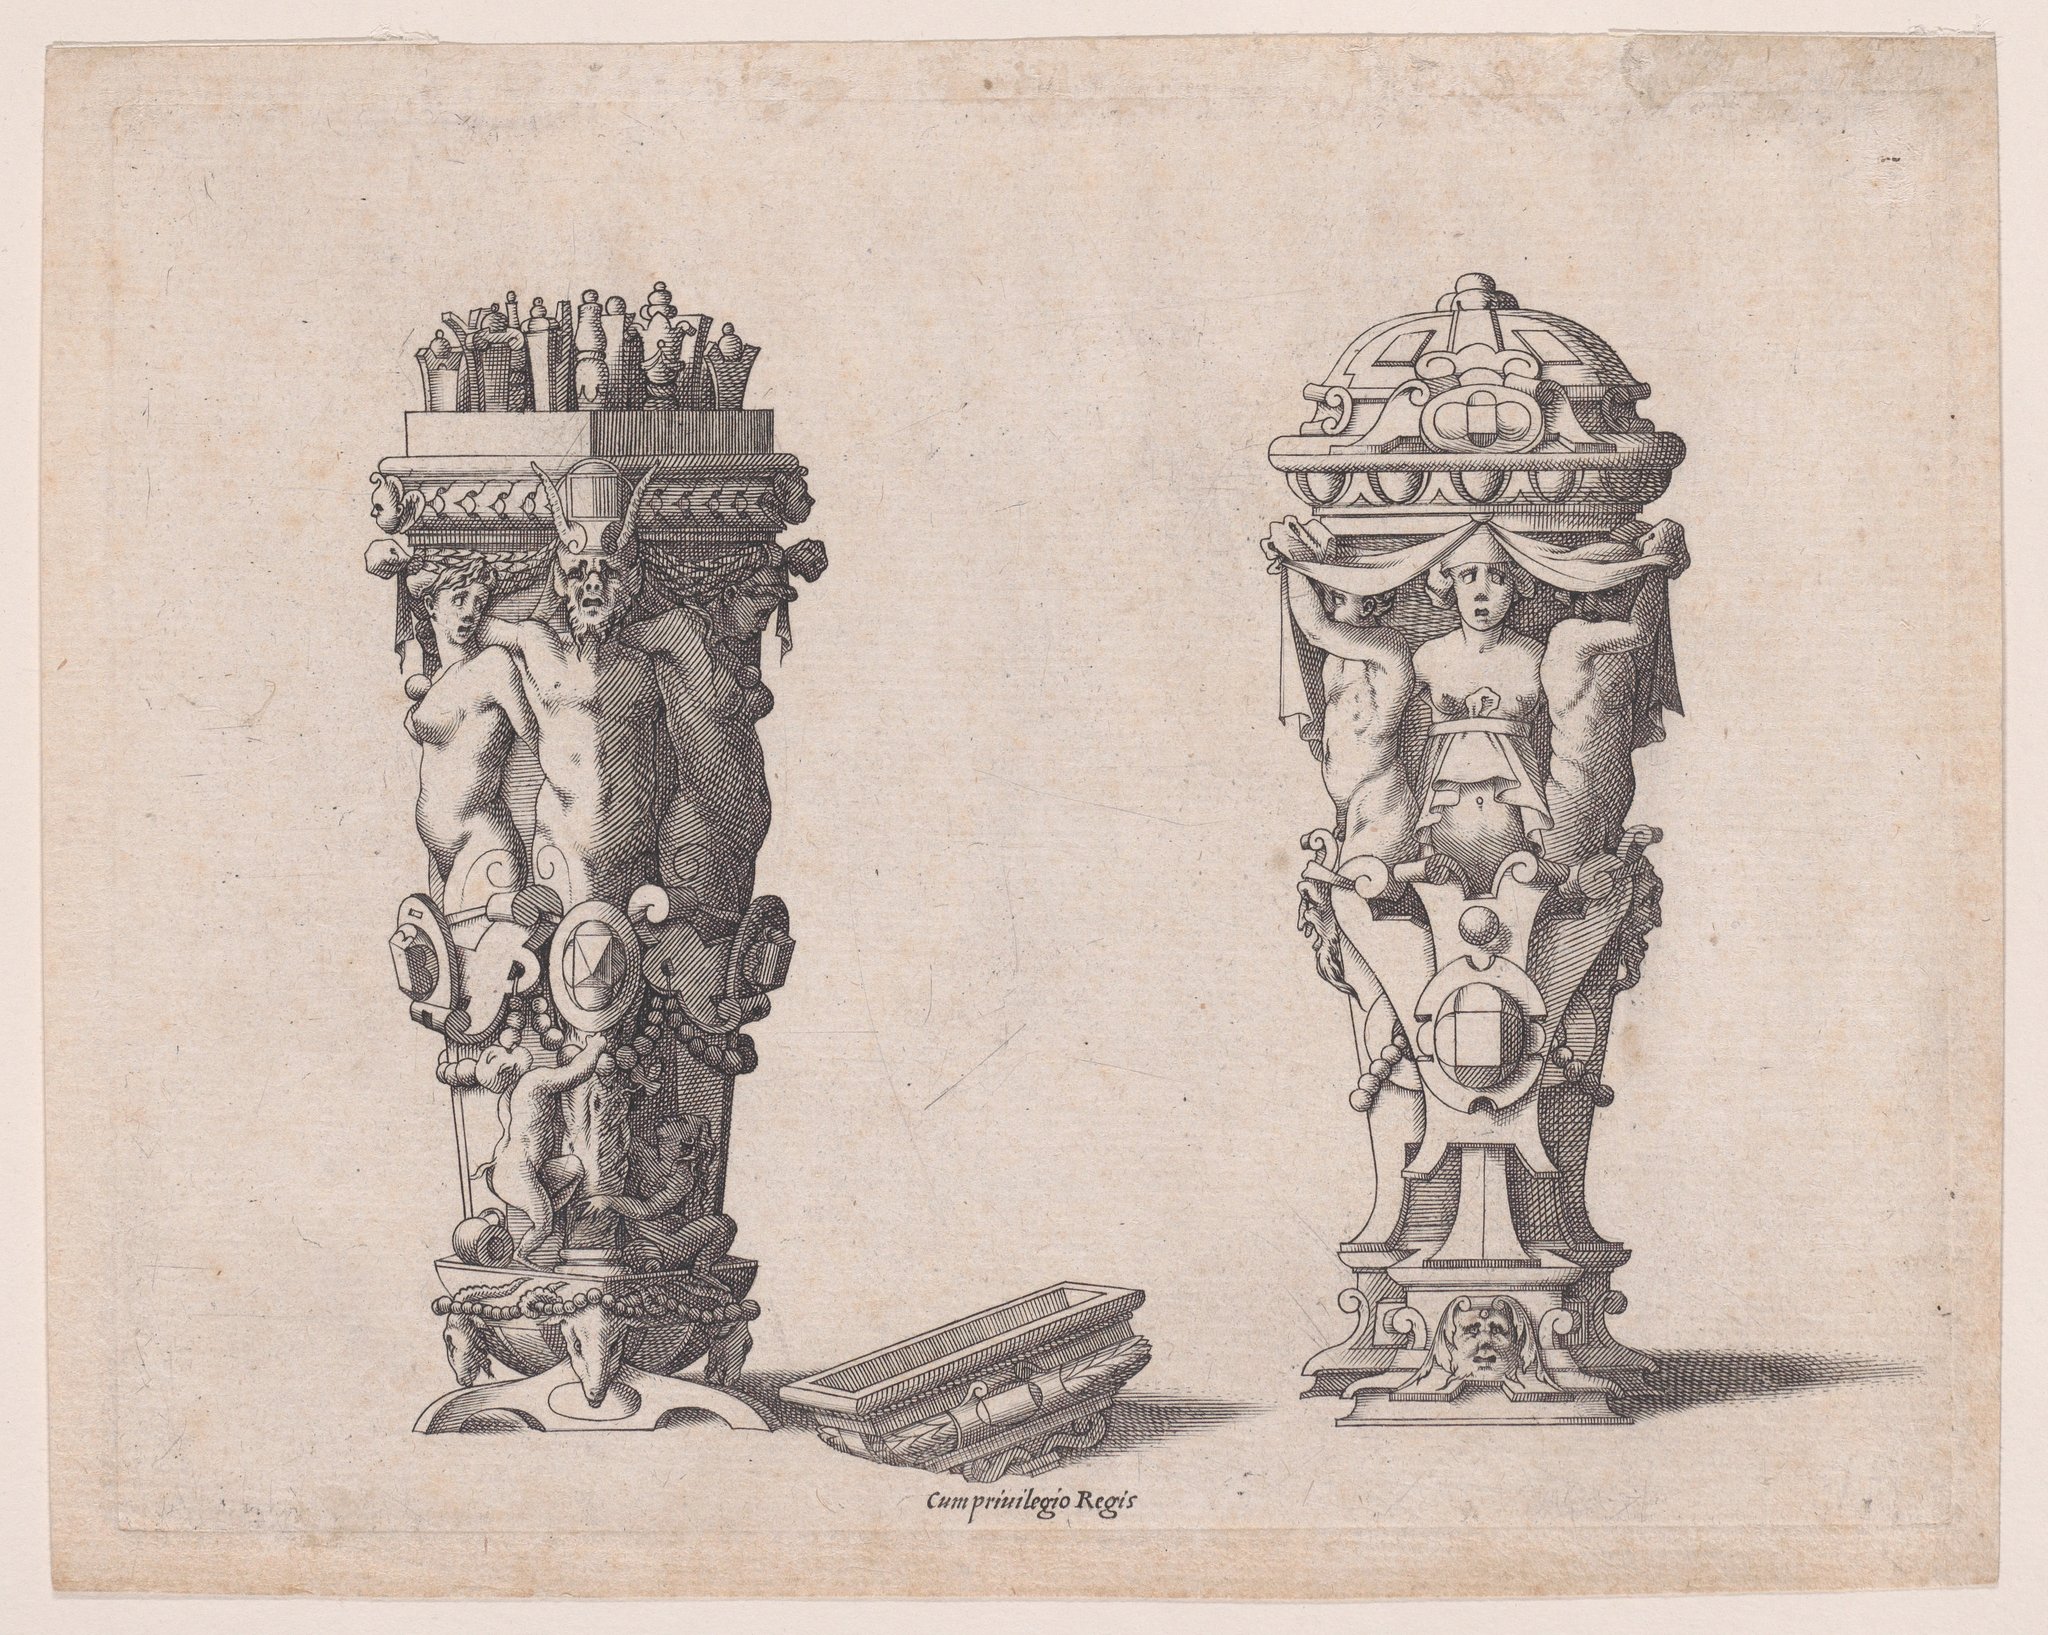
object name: print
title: Two Containers (Deux nécessaires)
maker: rené boyvin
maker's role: artist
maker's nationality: french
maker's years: 1525-1598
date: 1525-1600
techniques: engraving